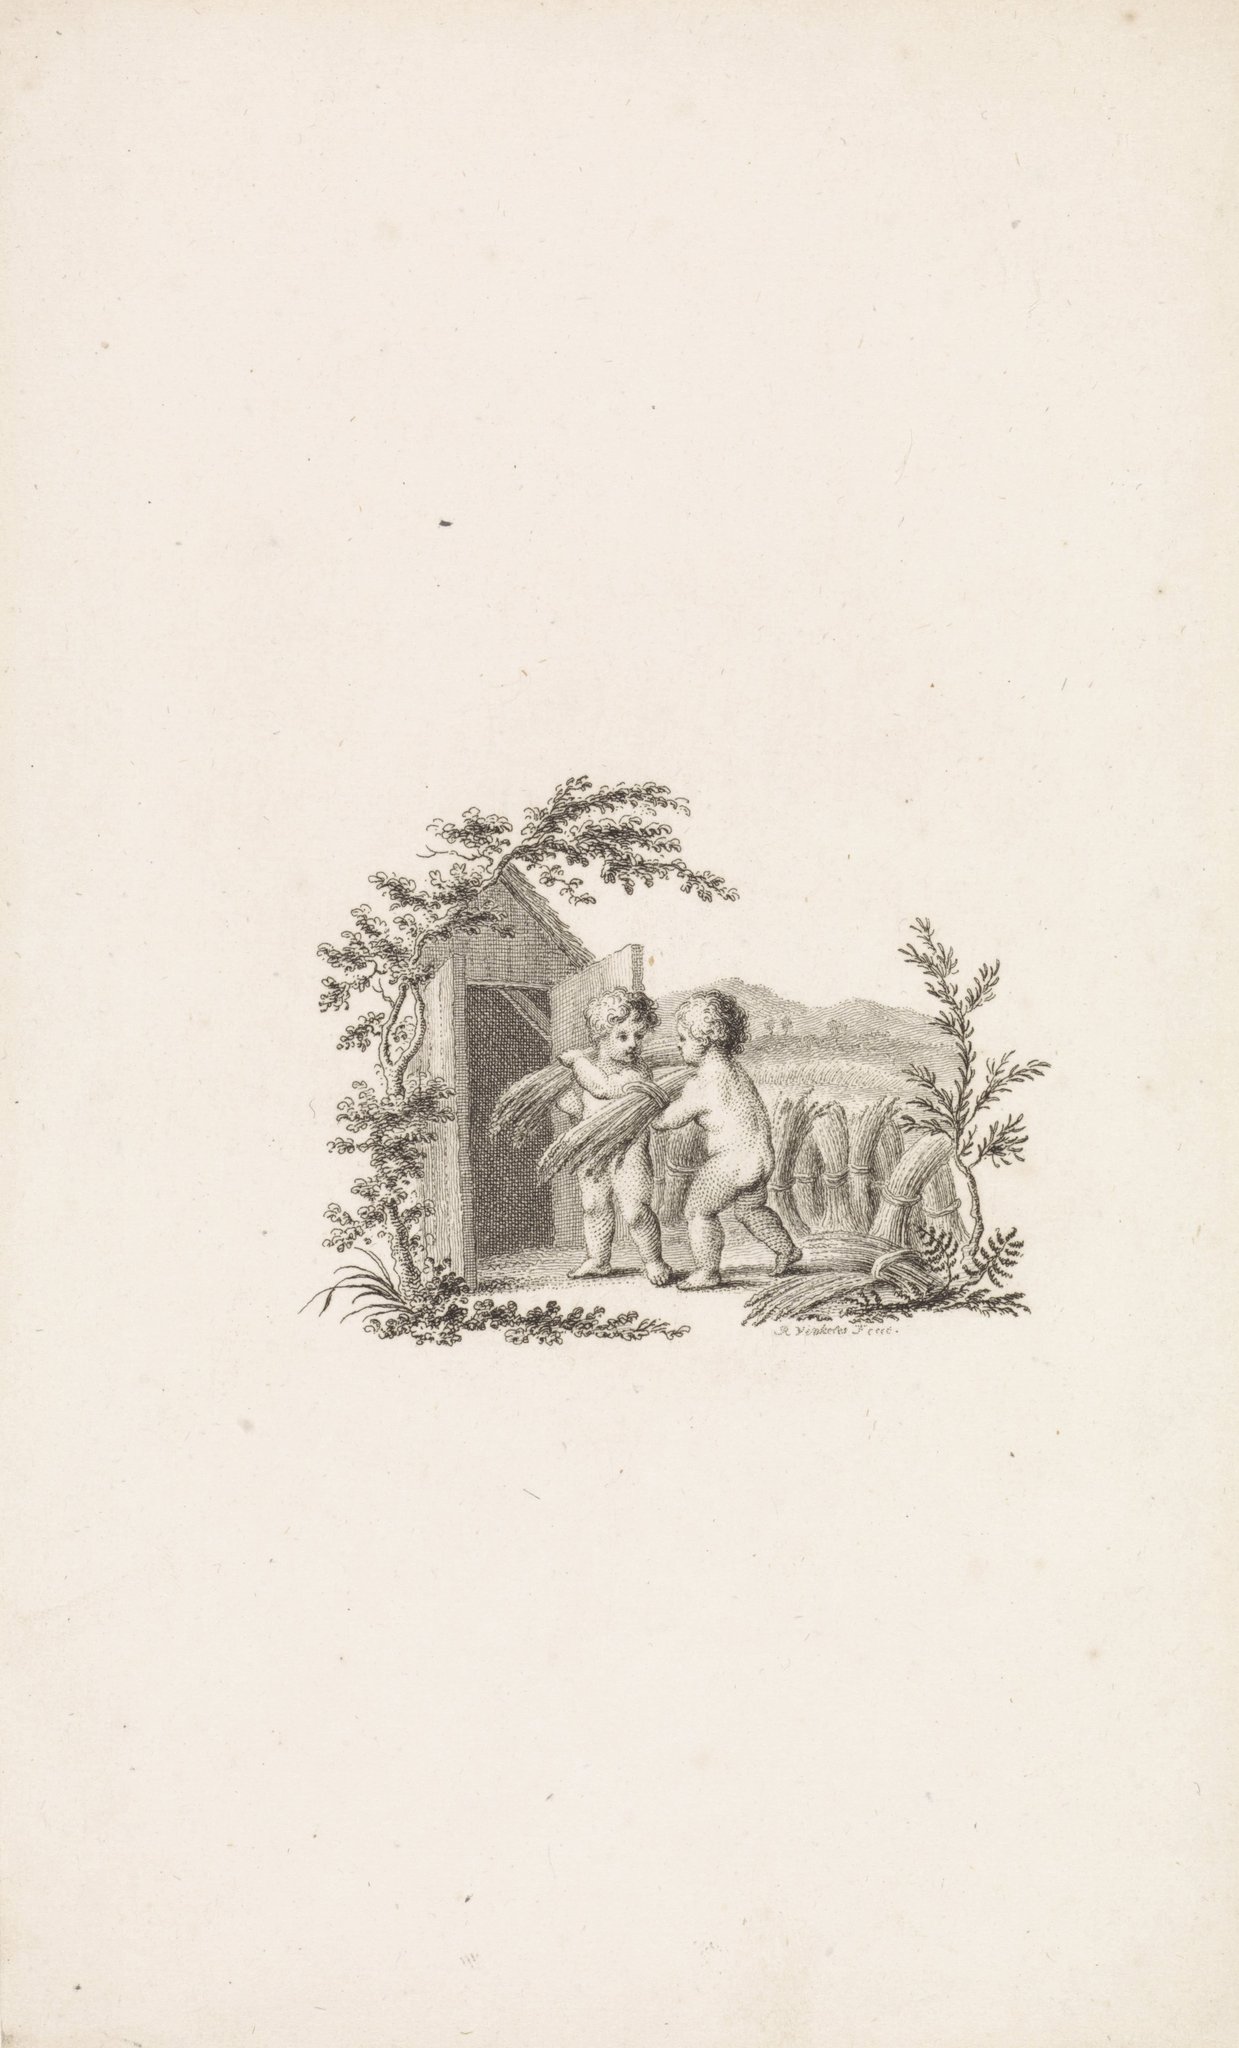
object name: print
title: Twee putti brengen korenschoven naar een schuur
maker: reinier vinkeles (i)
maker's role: draughtsman, print maker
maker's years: 1741-1816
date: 1751-1816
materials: paper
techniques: engraving, etching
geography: amsterdam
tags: sheaf of corn as attribute of ceres, cupids: 'amores', 'amoretti', 'putti'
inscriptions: collector's mark: Lugt 2228